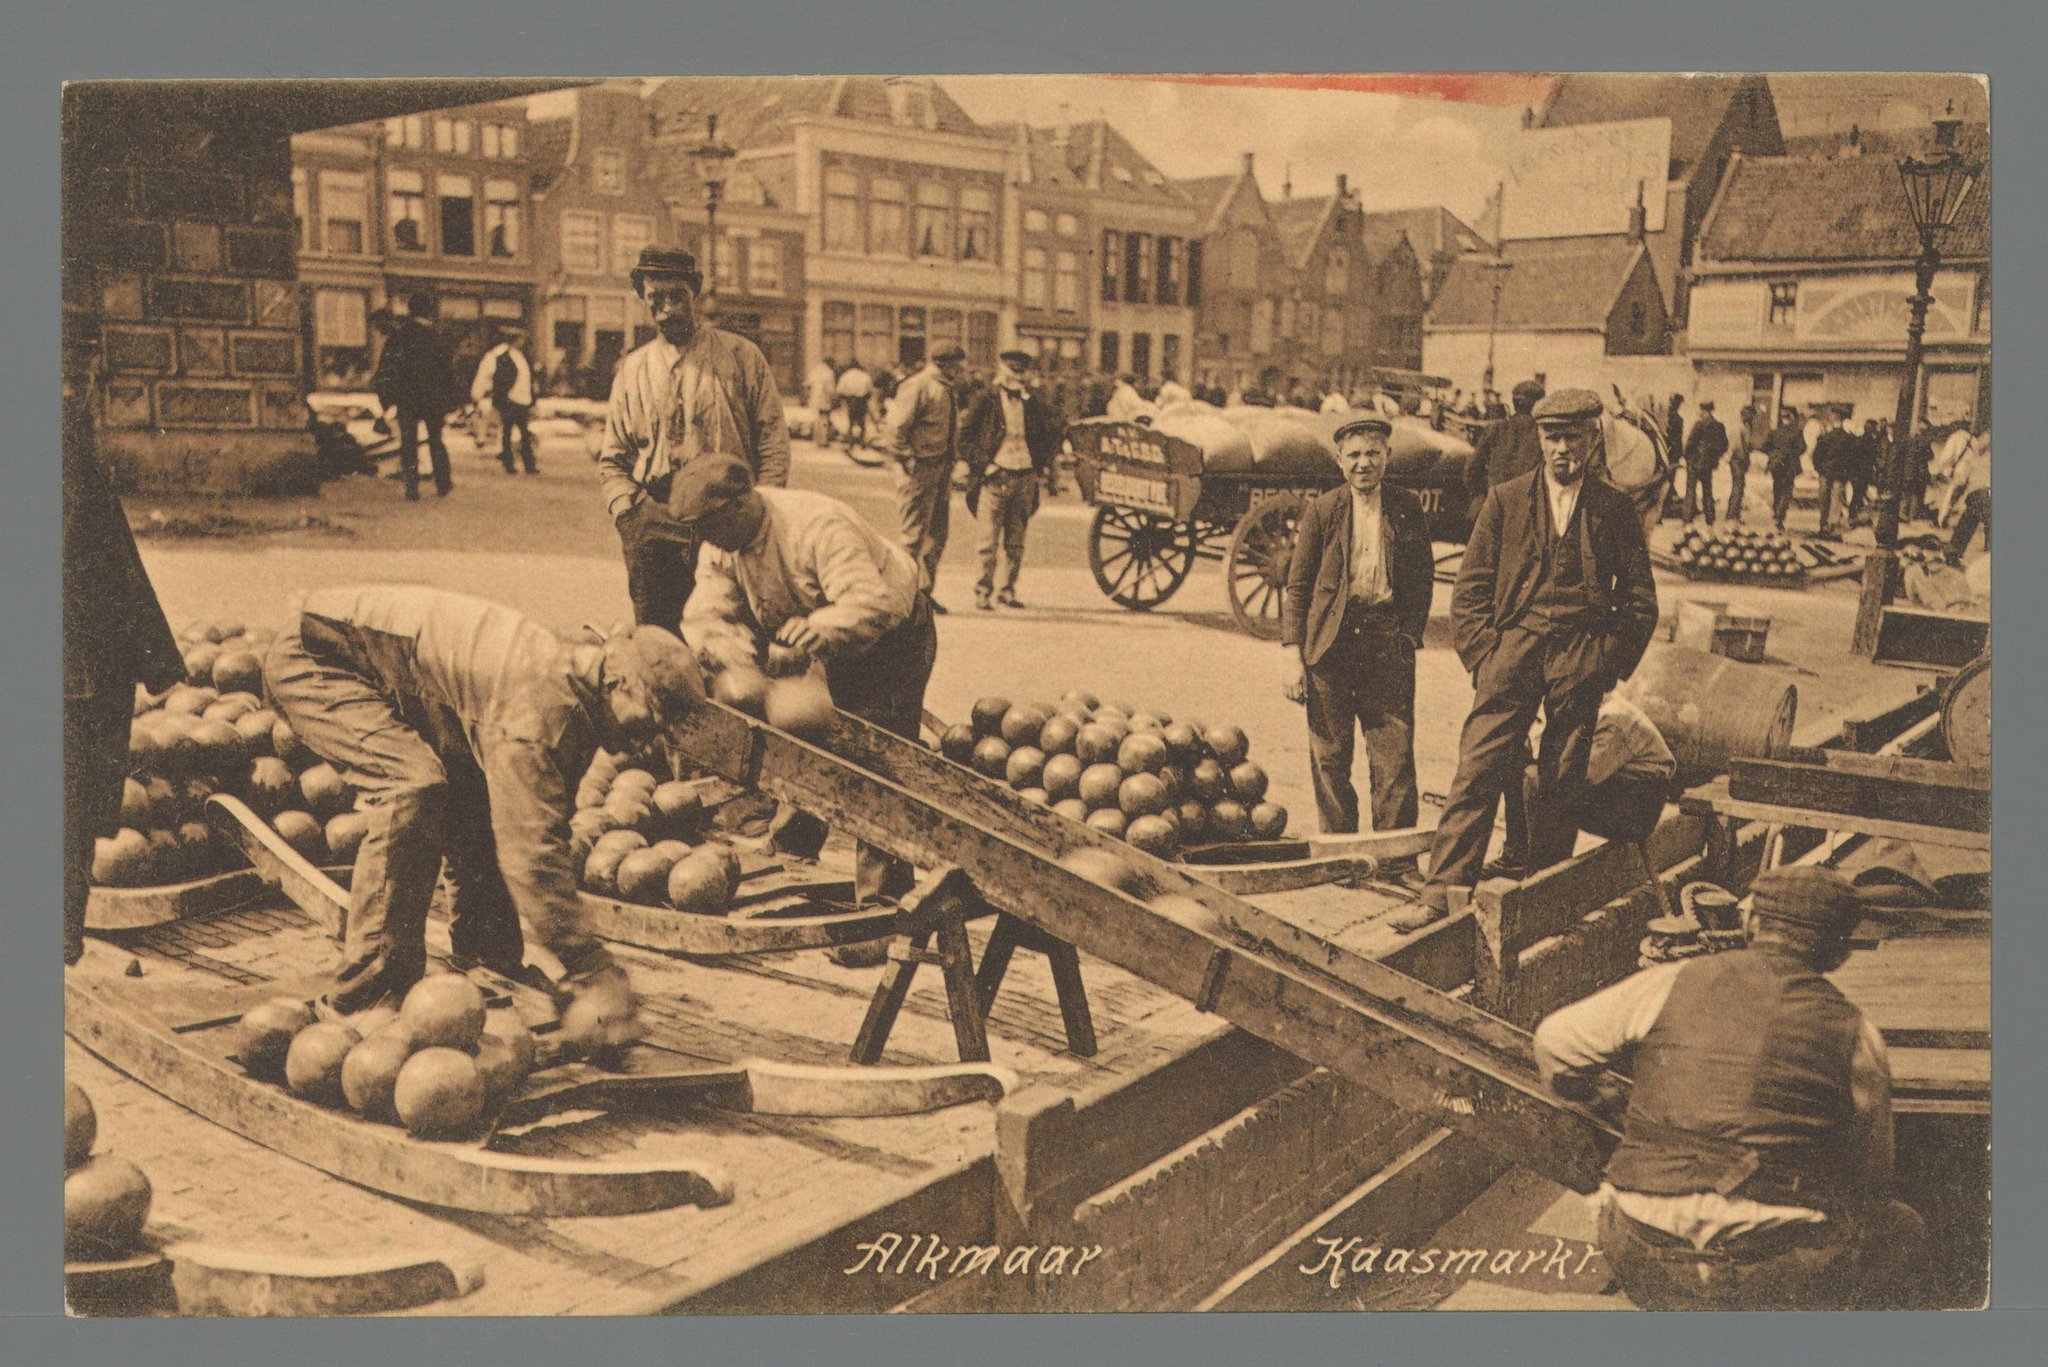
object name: photomechanical print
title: Alkmaar. Kaasmarkt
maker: Anonymous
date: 1909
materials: cardboard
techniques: photograph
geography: leipzig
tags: farmers, cheese